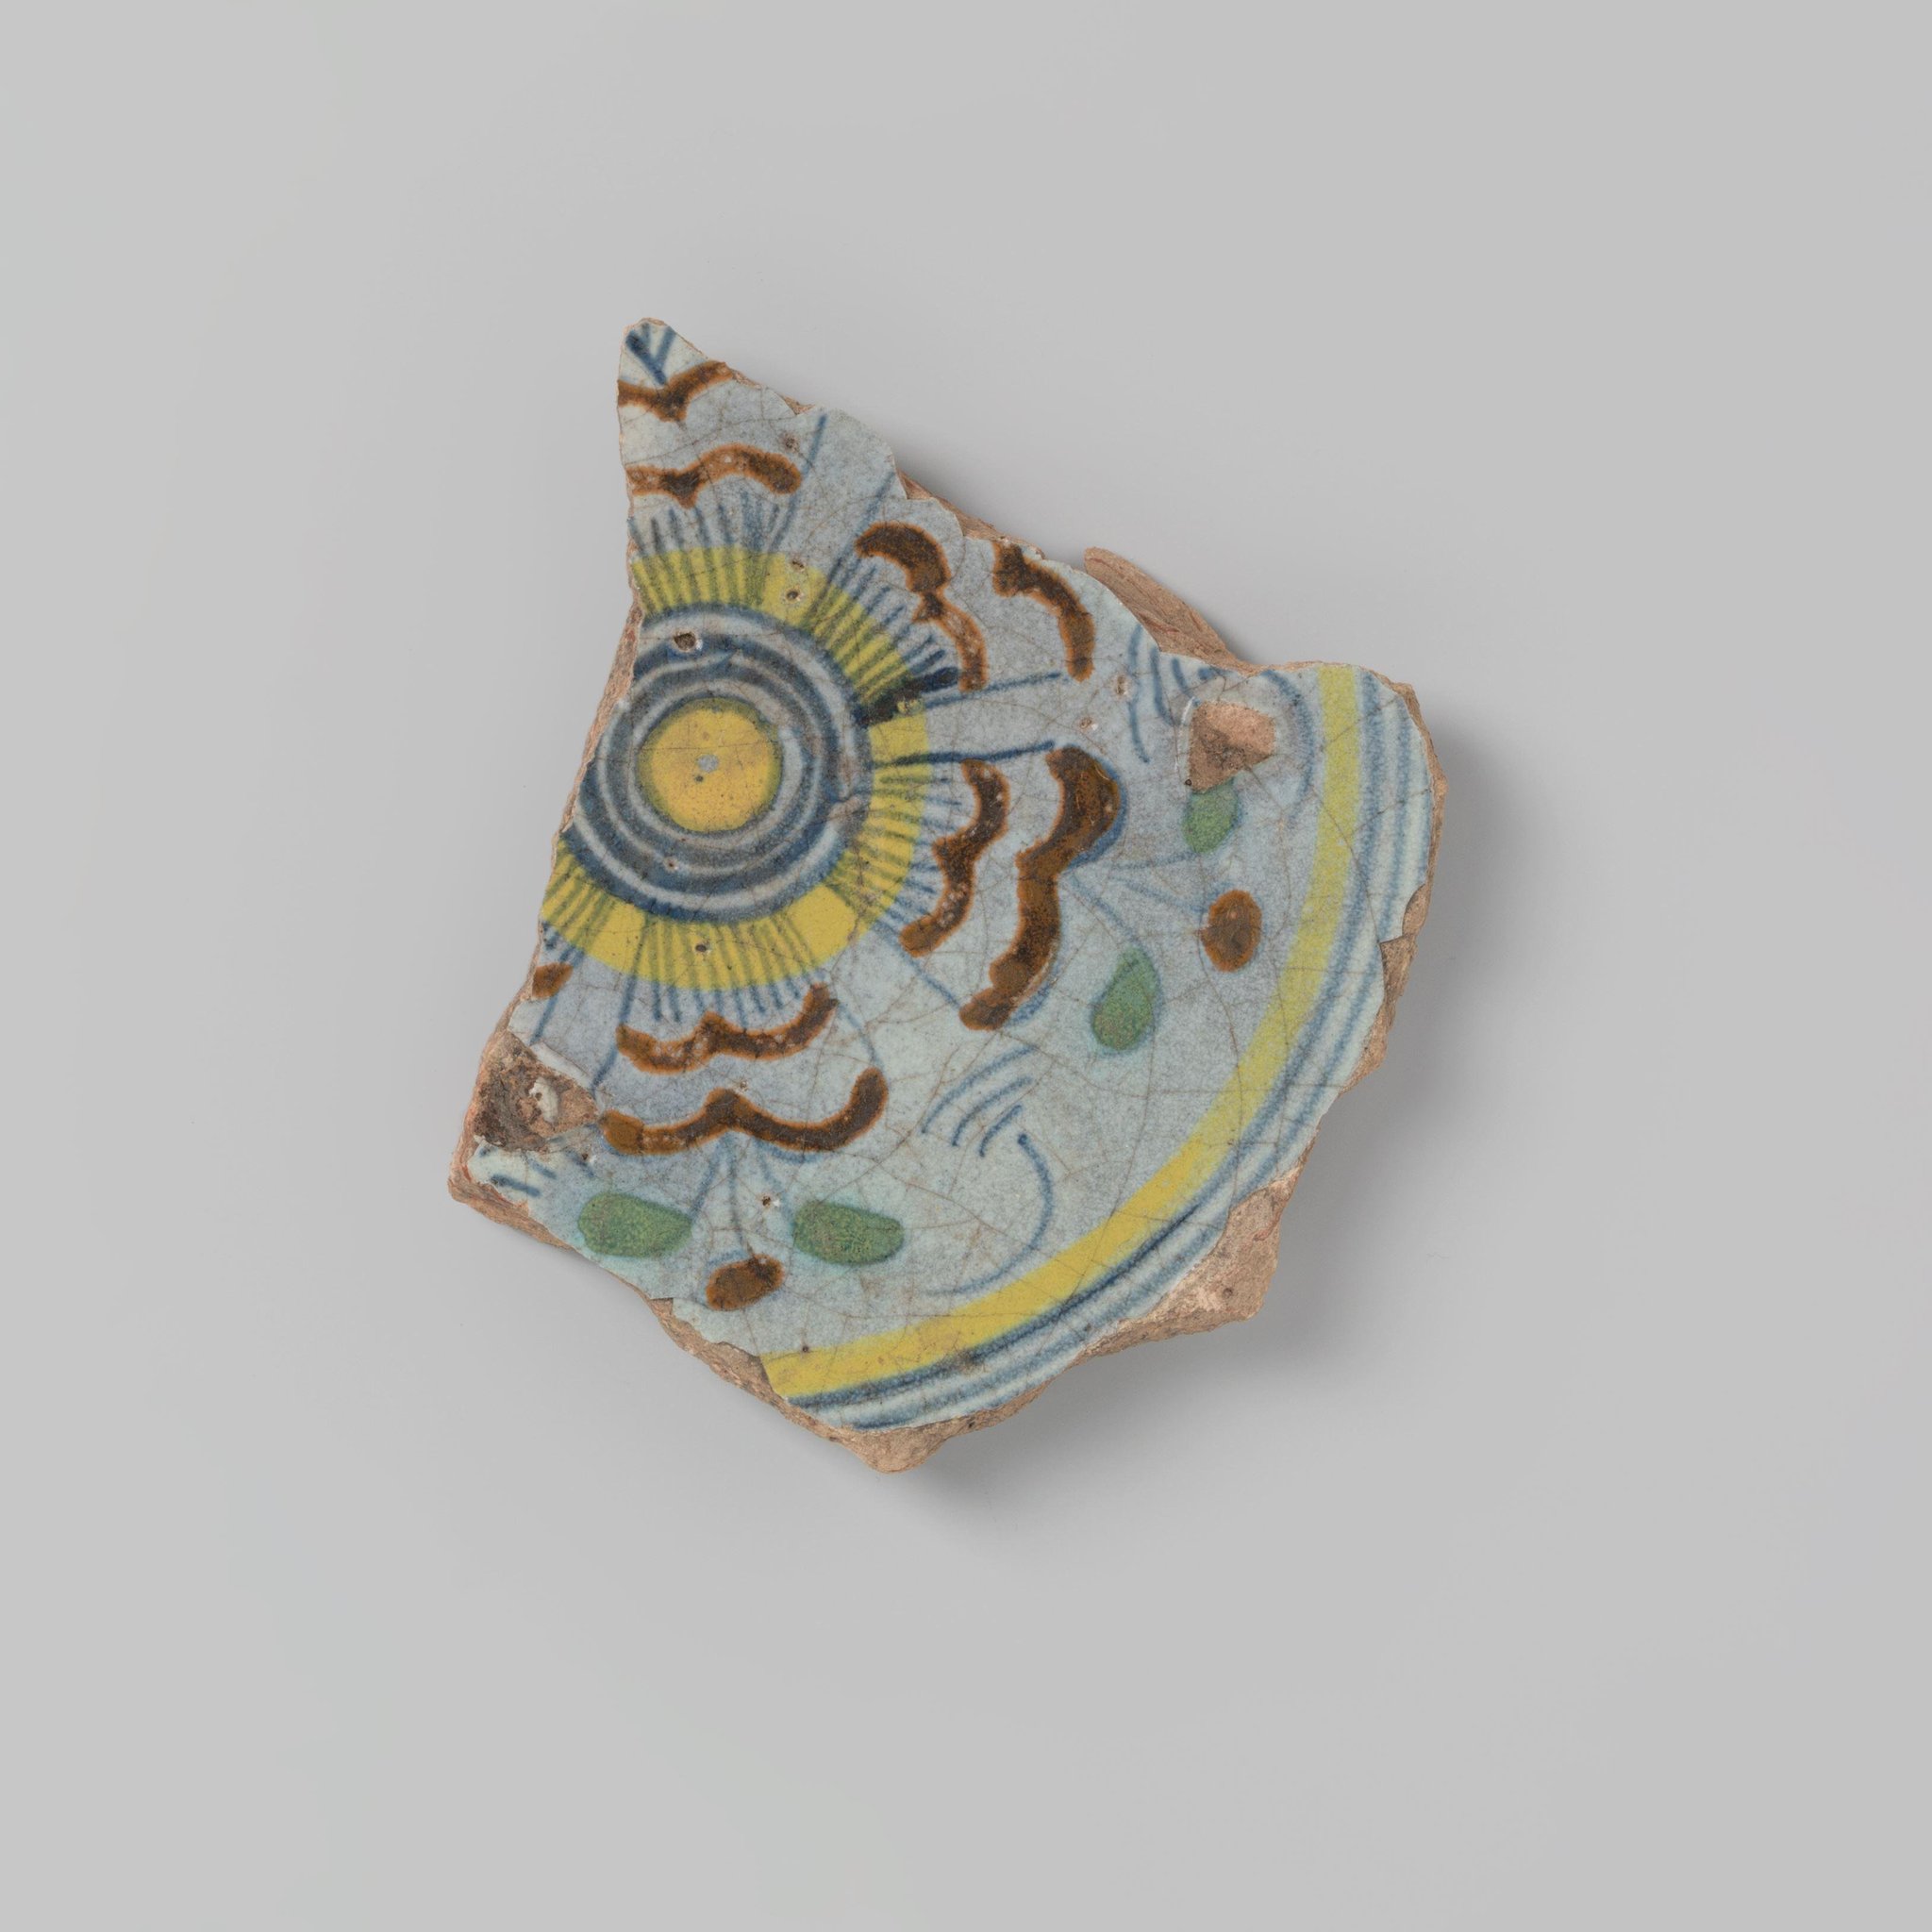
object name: sherd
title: Schotelscherf van aardewerk voorzien van een veelkleurige tekening van een bloem in een cirkel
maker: Anonymous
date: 1500-1799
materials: earthenware, glaze